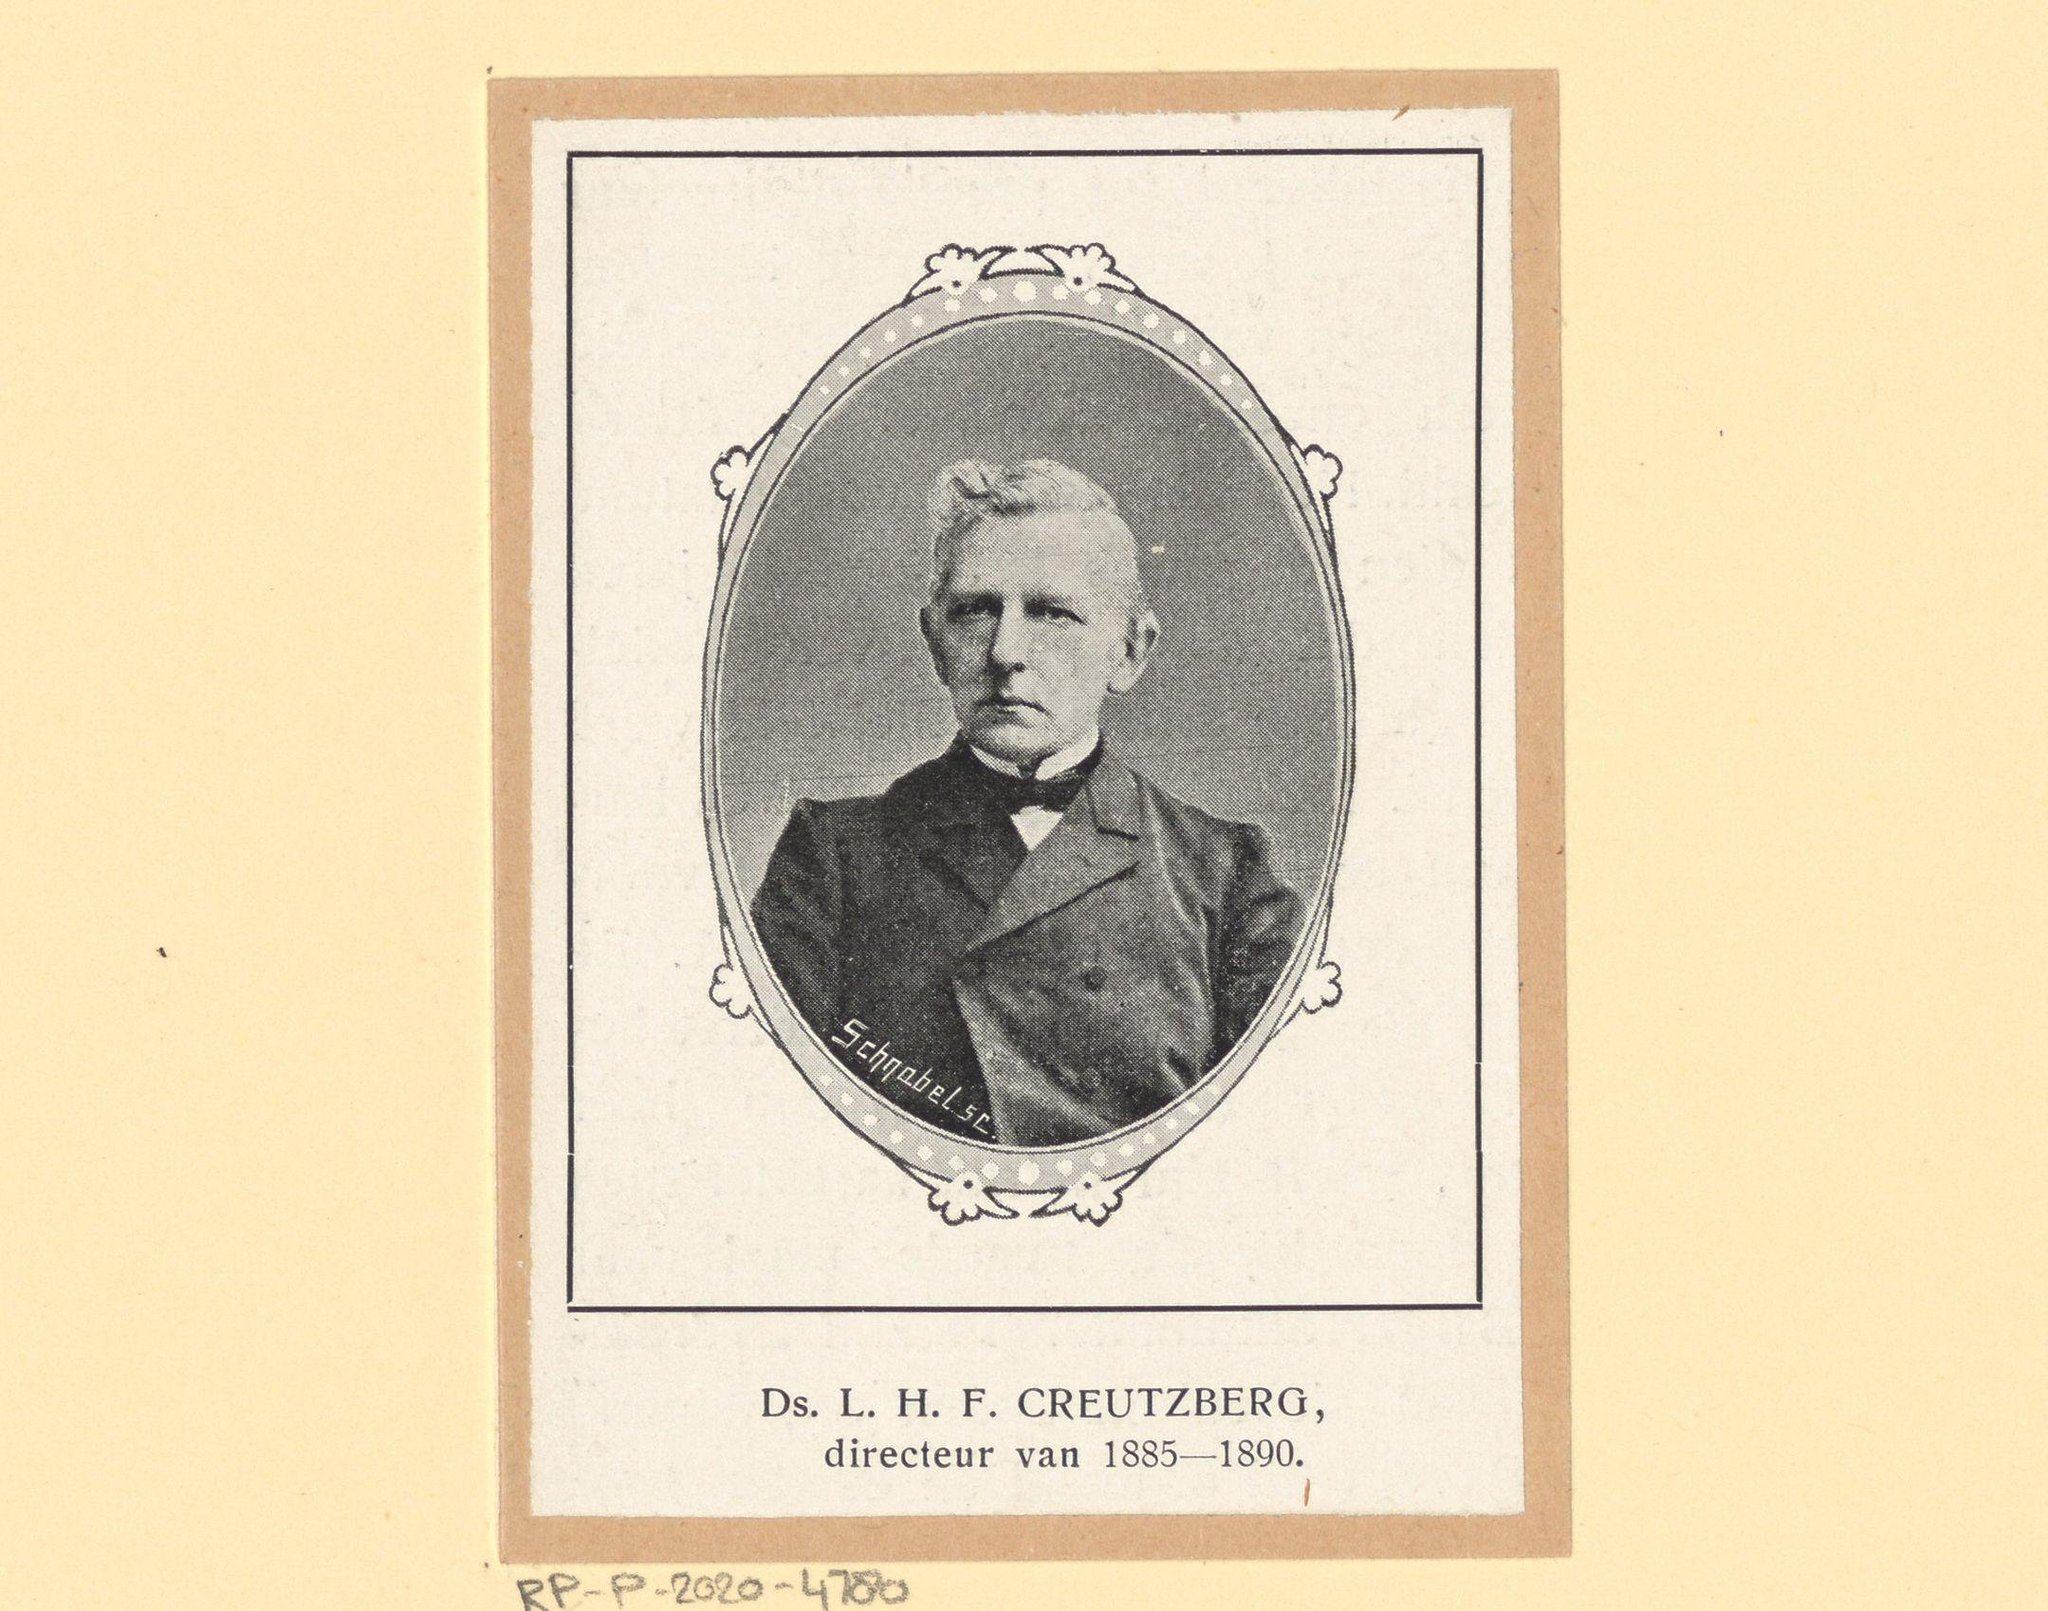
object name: photomechanical print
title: Portret van Lodewijk Hendrik Frederik Creutzberg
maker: dirk gerardus schnabel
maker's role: clichémaker, fotograaf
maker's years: 1870-1933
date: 1890-1933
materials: paper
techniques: letterpress printing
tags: historical persons